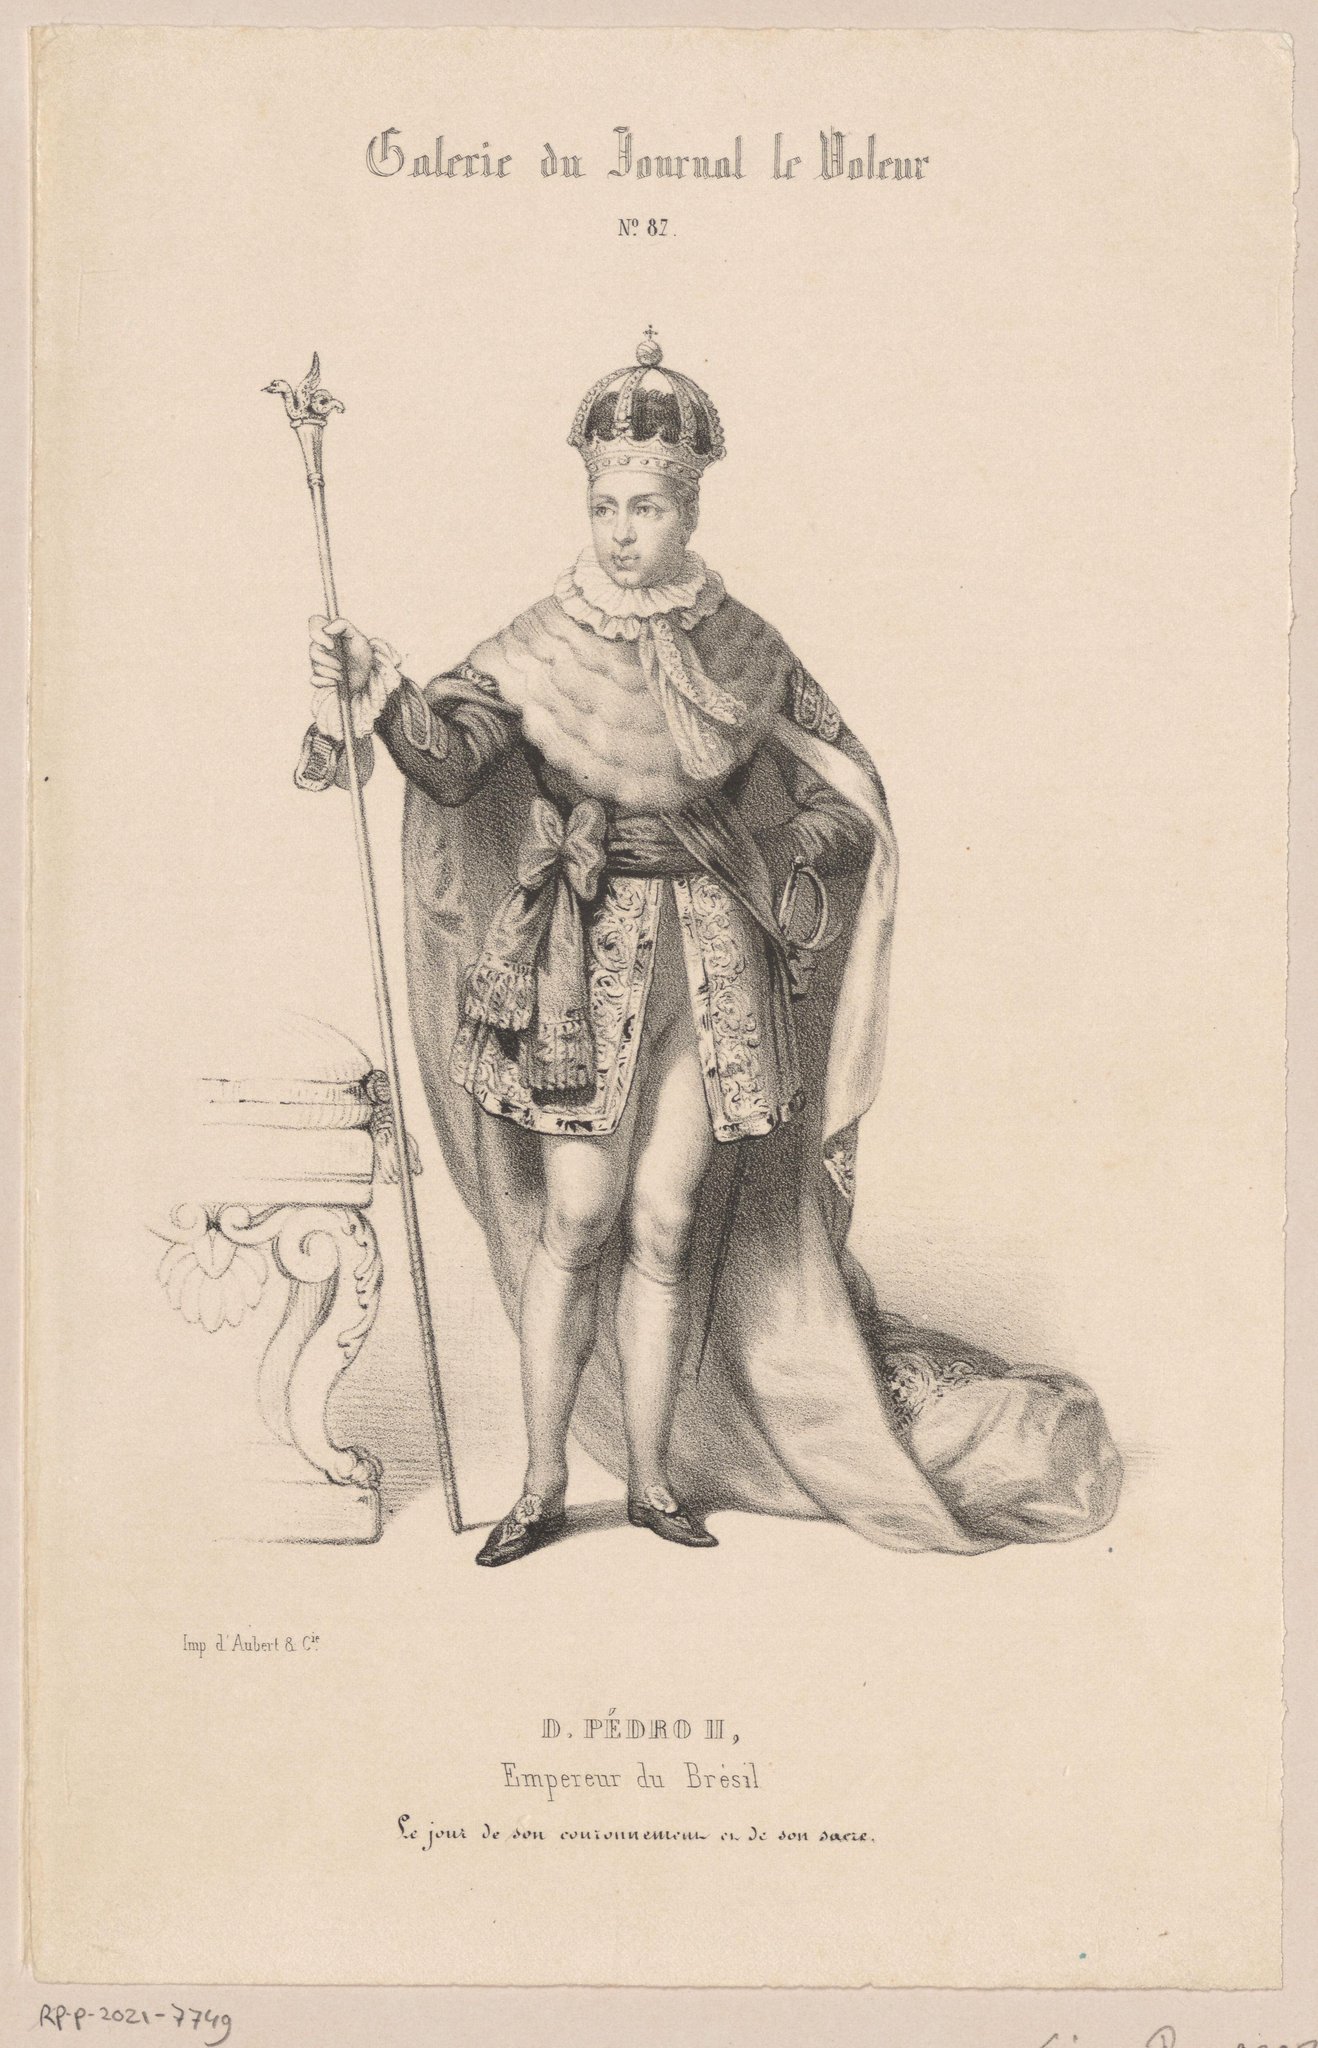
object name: print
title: Portret van Peter II, keizer van Brazilië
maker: Anonymous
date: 1828-1851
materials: paper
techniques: lithograph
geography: paris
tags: adult man, historical persons, king